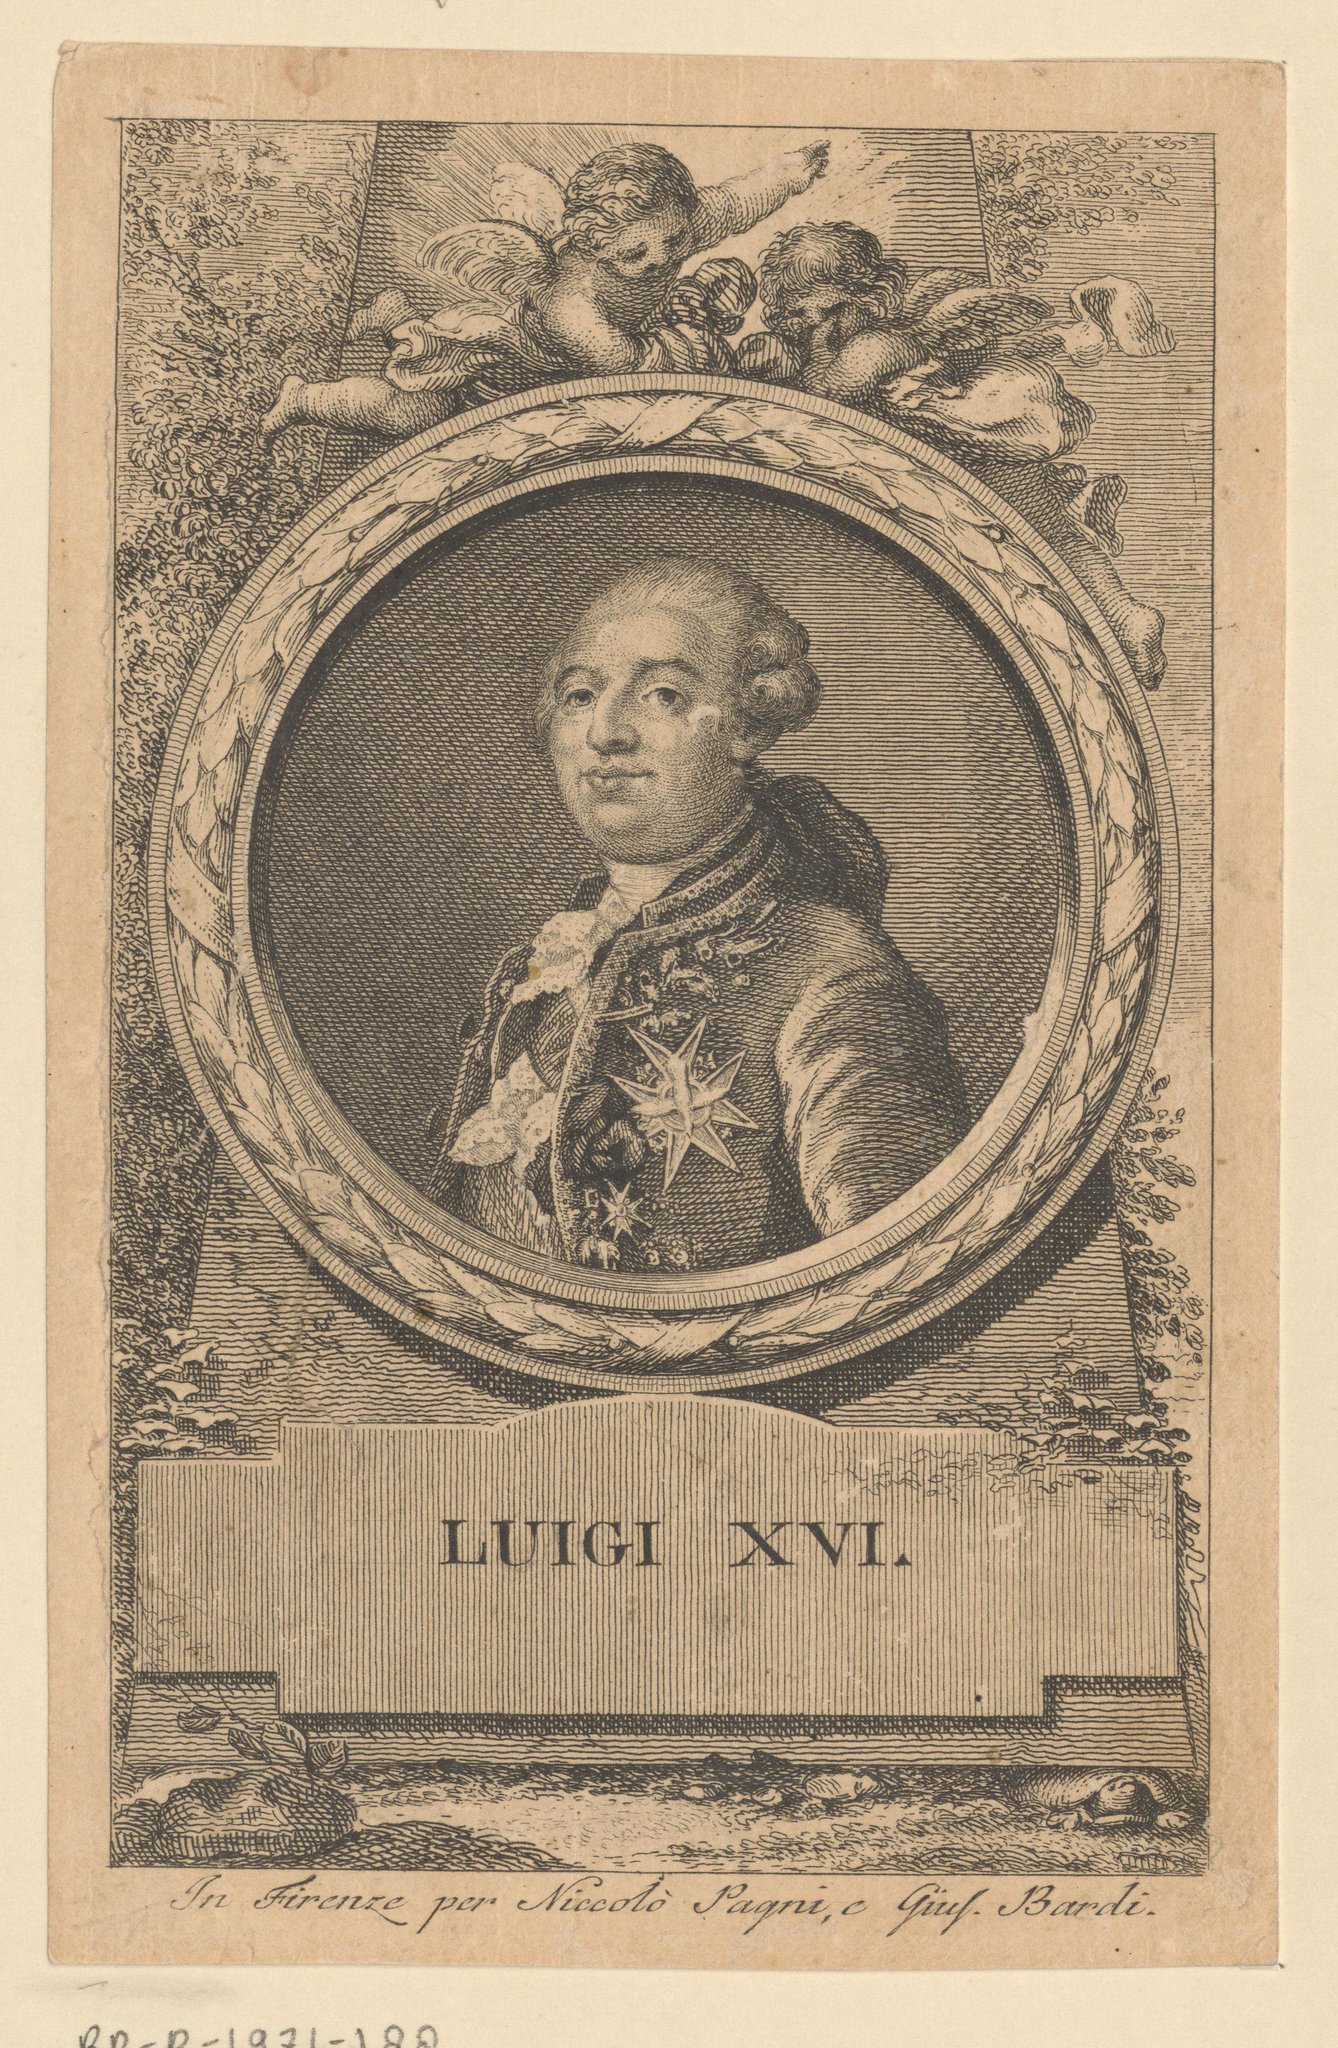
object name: print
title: Portret van Lodewijk XVI van Frankrijk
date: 1793-1795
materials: paper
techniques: etching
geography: florence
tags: lodewijk xvi (koning van frankrijk), ornament ~ medallion, historical persons, cupids: 'amores', 'amoretti', 'putti', king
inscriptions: number: ‘452/ 36’, collector's mark: Lugt 2228, collector's mark: Lugt 2760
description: Het portret in medaillon wordt door twee putti opgehouden tegen een gedenkmonument.